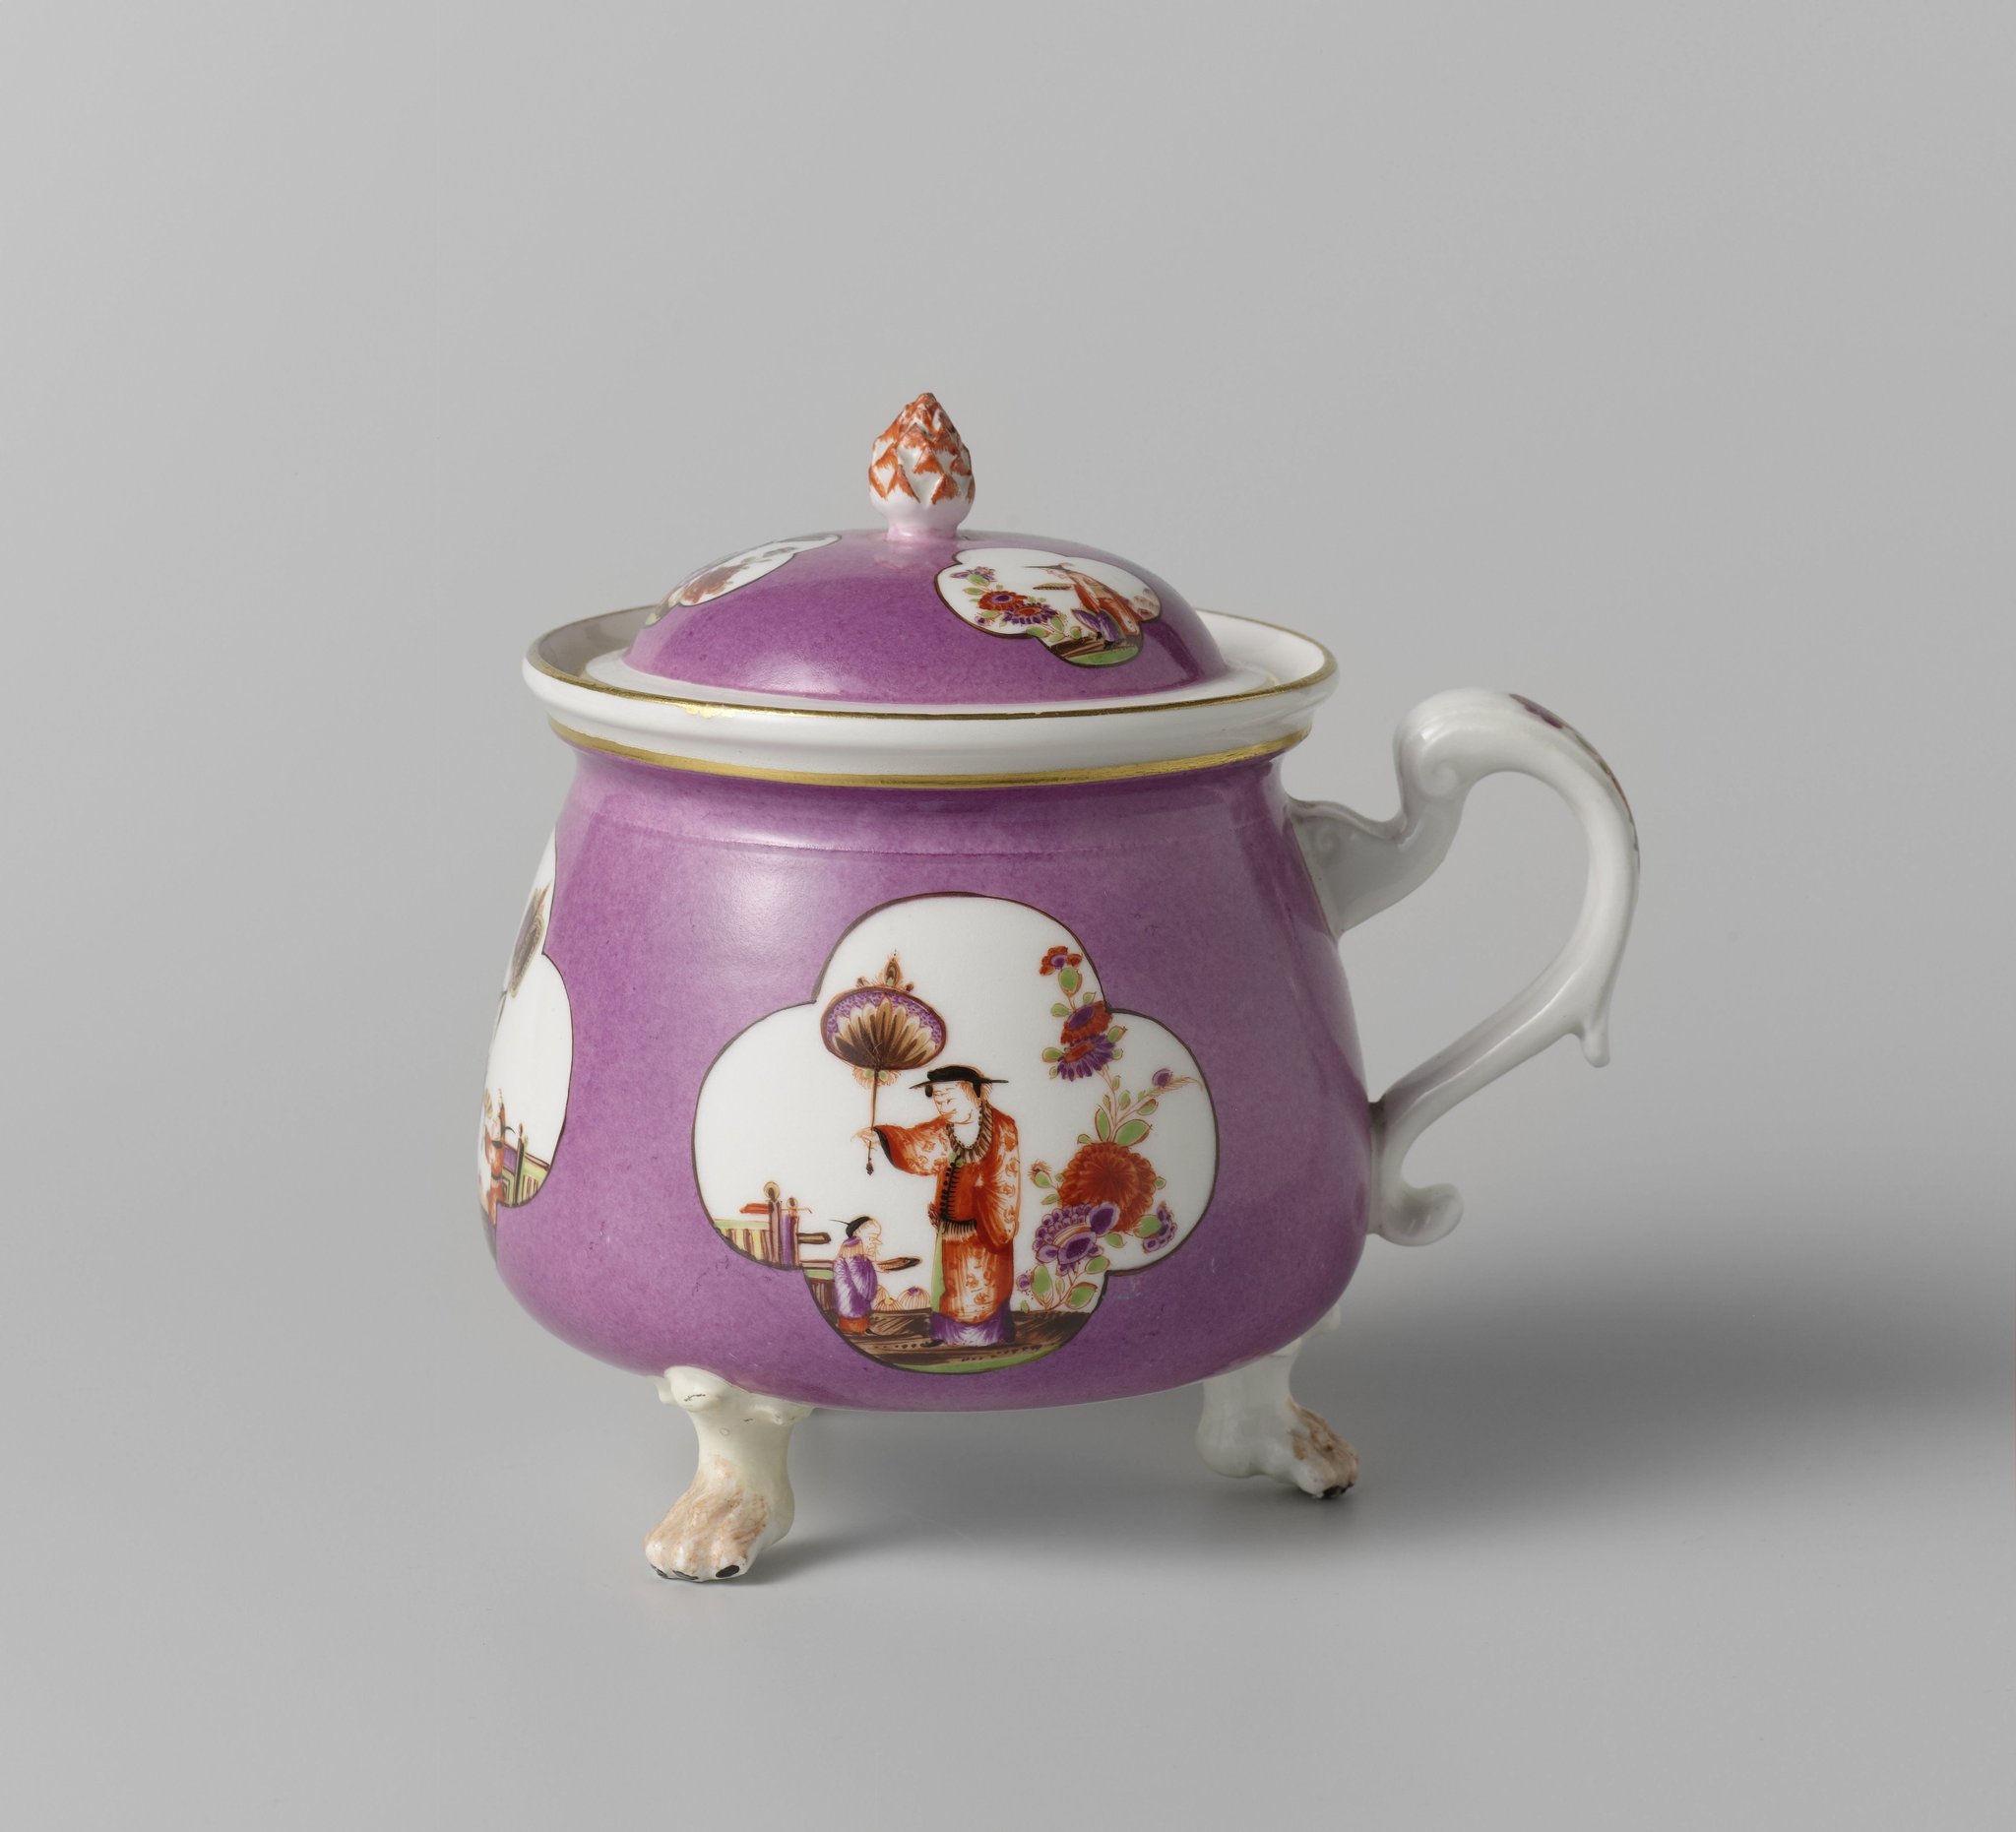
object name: eating drinking utensil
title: Roompot met deksel, veelkleurig beschilderd met chinoiserieën in uitgespaarde vierpassen in een violette fond op onderschotel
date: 1730-1735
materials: porcelain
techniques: painted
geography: meissen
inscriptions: factory mark, mark: ‘4’, label: ‘SAMMLUNG / Dr. FRANZ OPPENHEIMER’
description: Cream pot and stand. Porcelain. Meissen, c. 1730 - 1735.